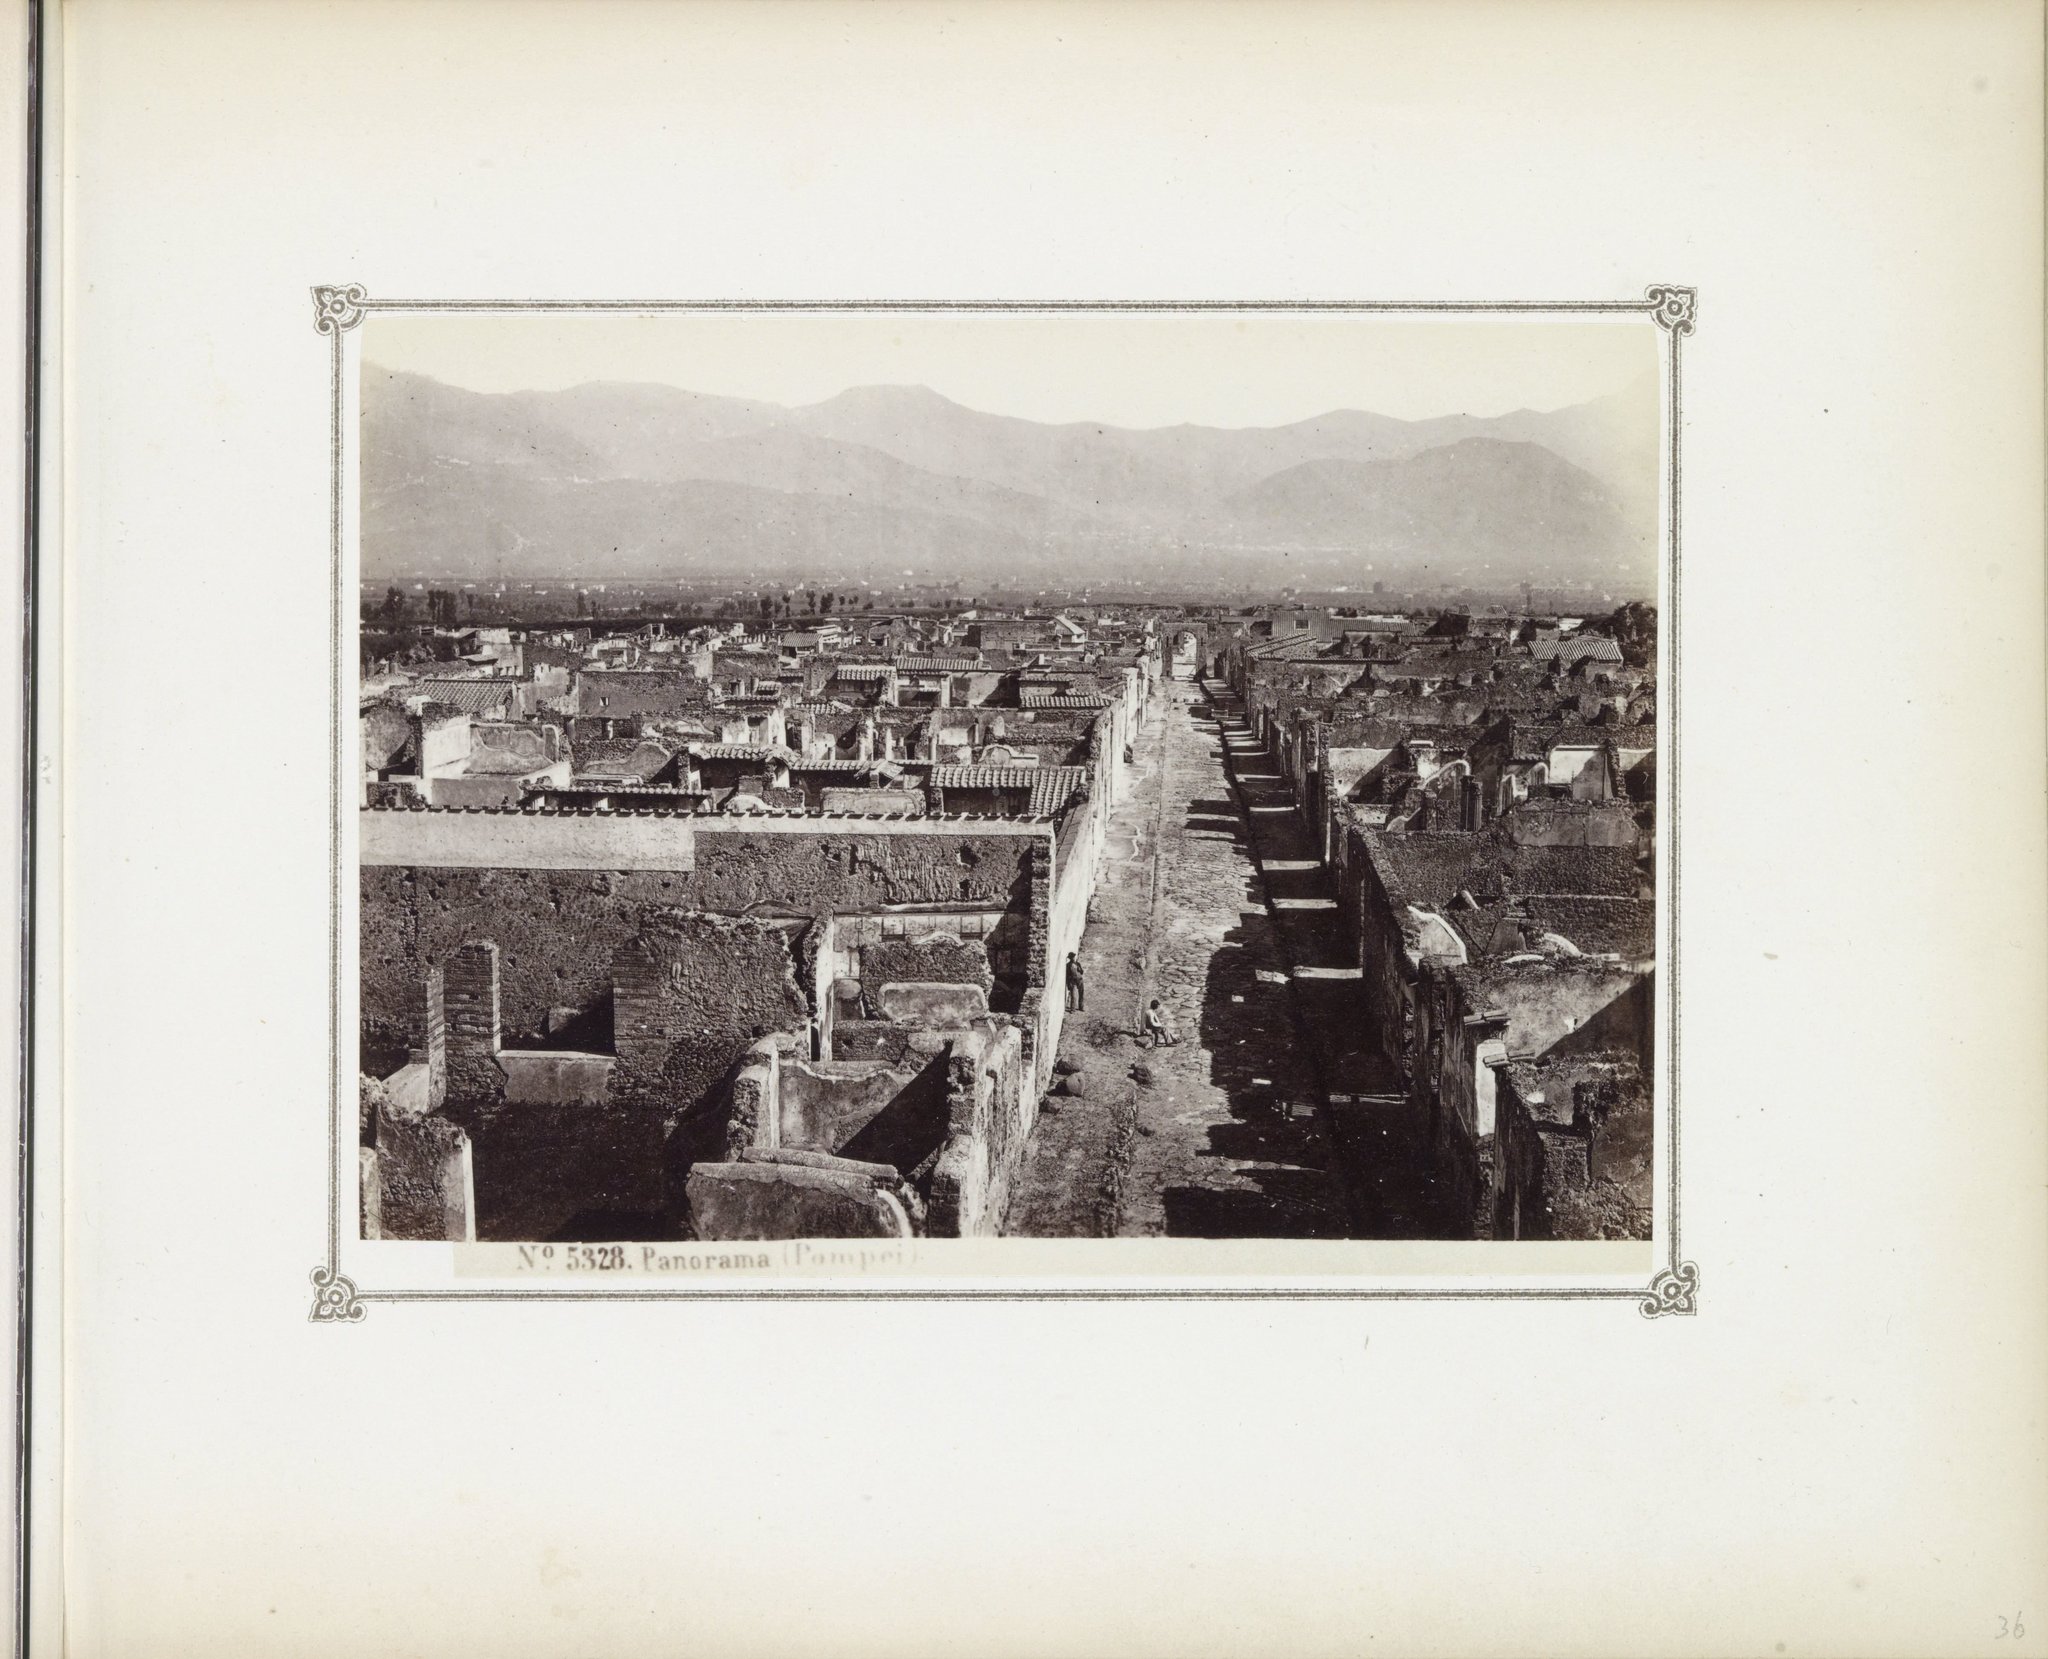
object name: photograph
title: Panorama (Pompei)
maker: giorgio sommer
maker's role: fotograaf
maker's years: 1834-1914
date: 1860-1900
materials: paper, photographic support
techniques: albumen print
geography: pompeii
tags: prospect of village, silhouette of village, excavation ~ archaeology, mountains, pompeii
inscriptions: number: ‘5328’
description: Onderdeel van Fotoalbum met opnames van opgravingen in Pompeï door Giorgio Sommer.